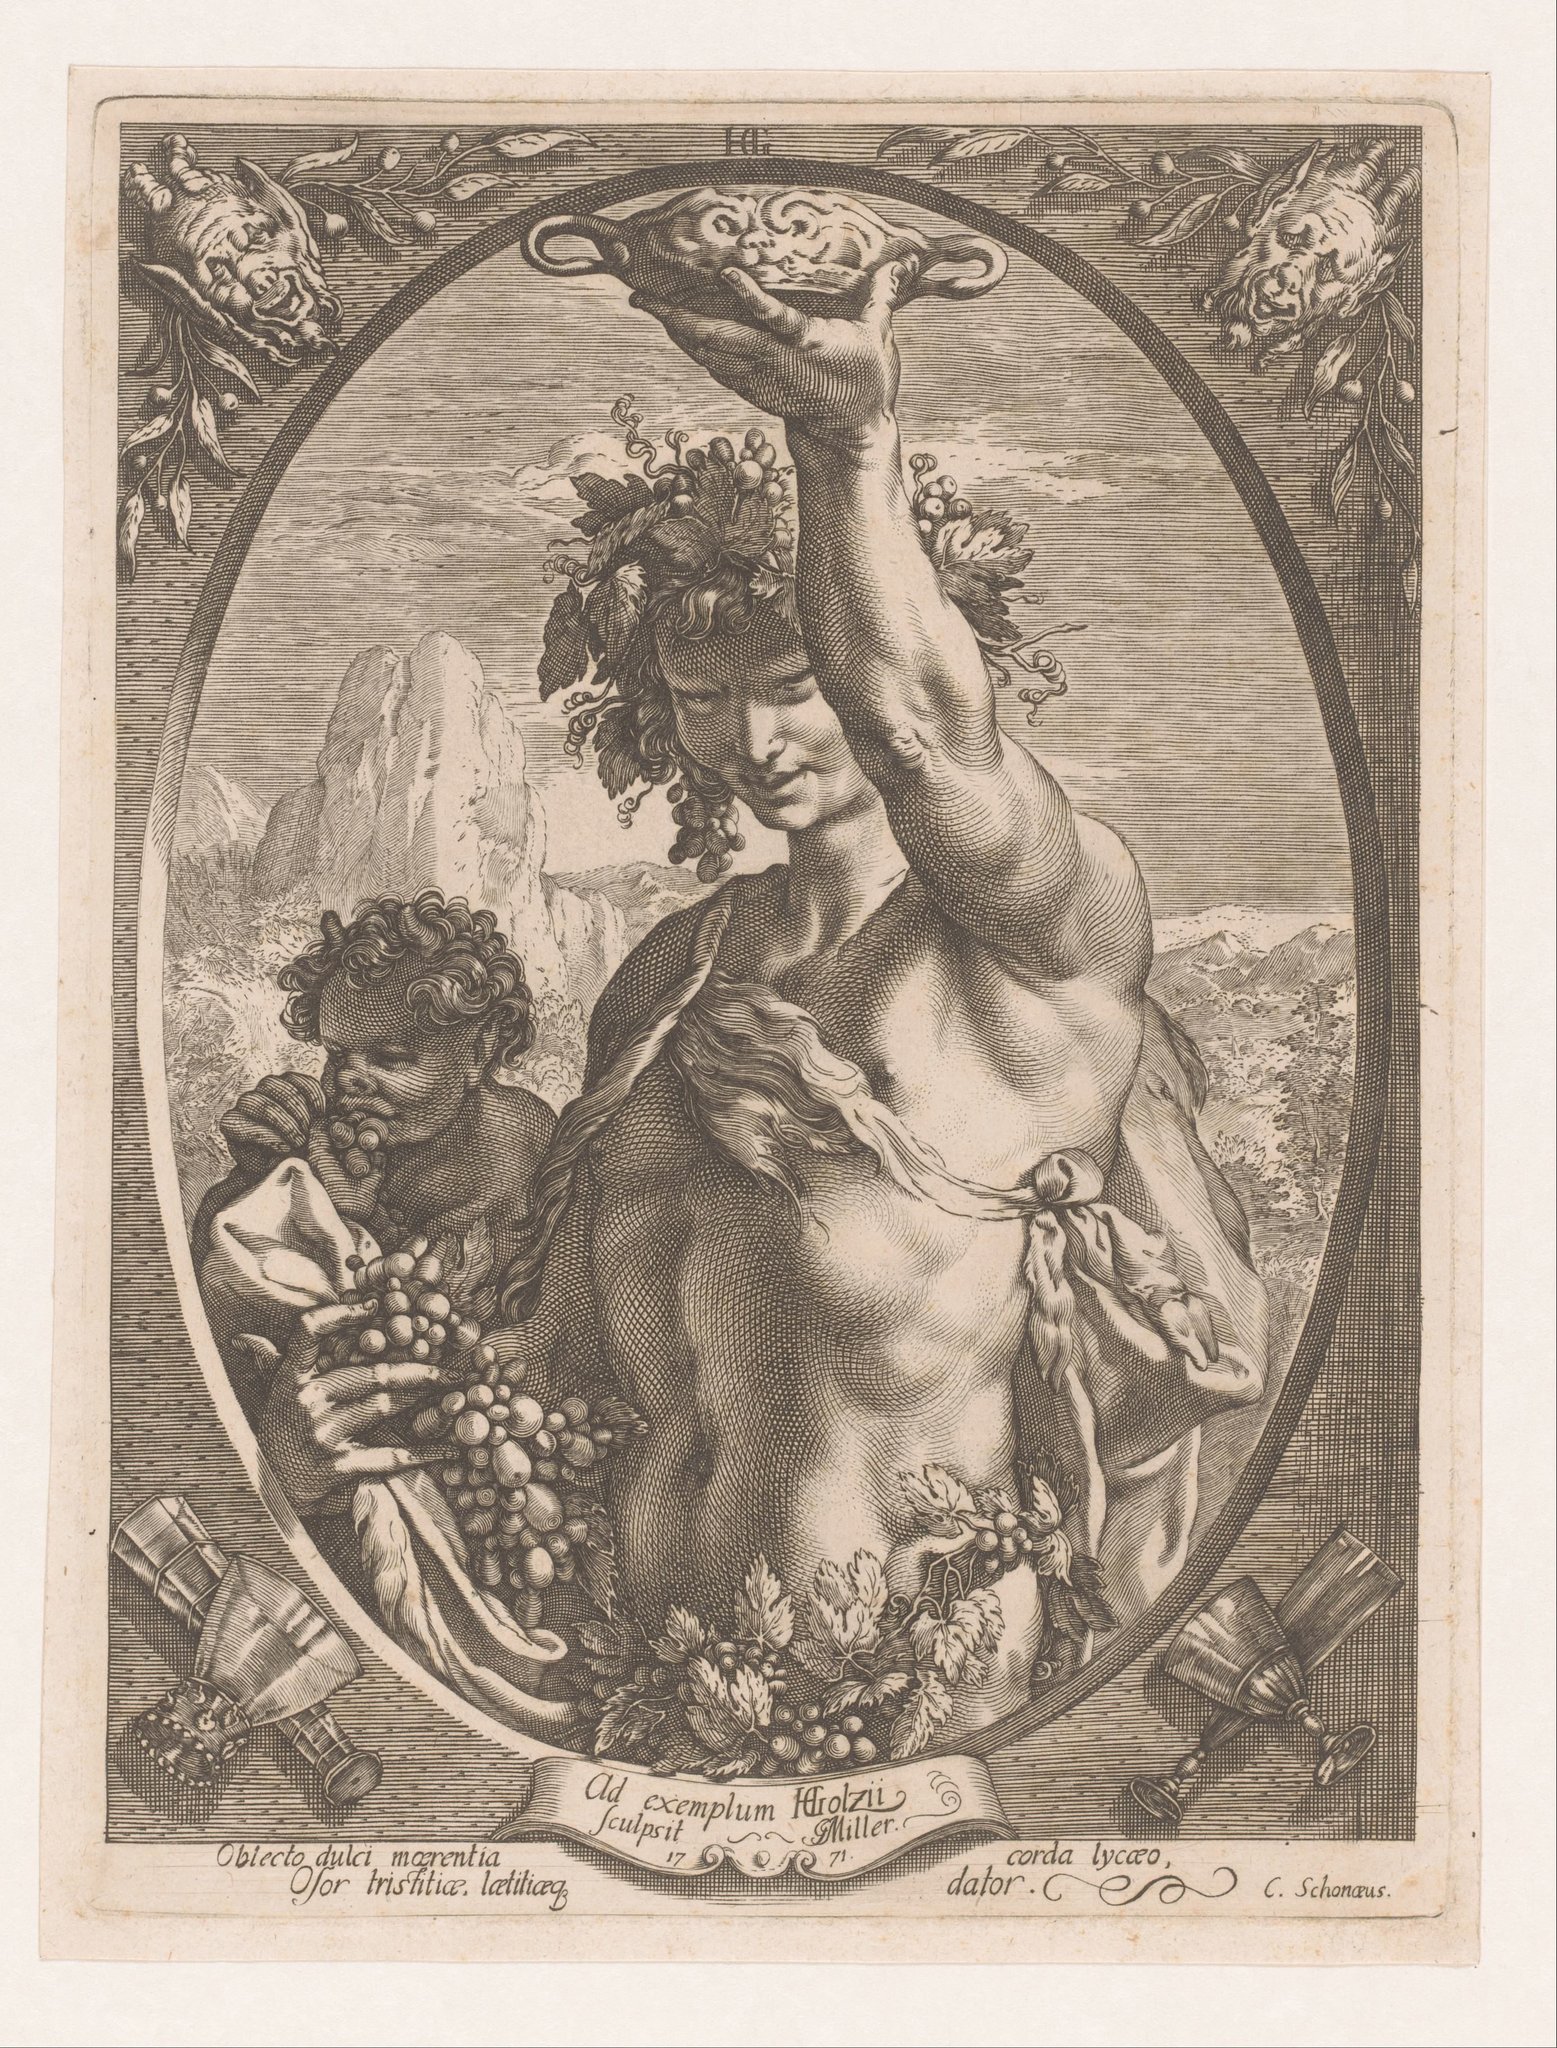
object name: print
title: Bacchus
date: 1771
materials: paper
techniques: engraving, etching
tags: (story of) bacchus (dionysus), liber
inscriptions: collector's mark: Lugt 2228